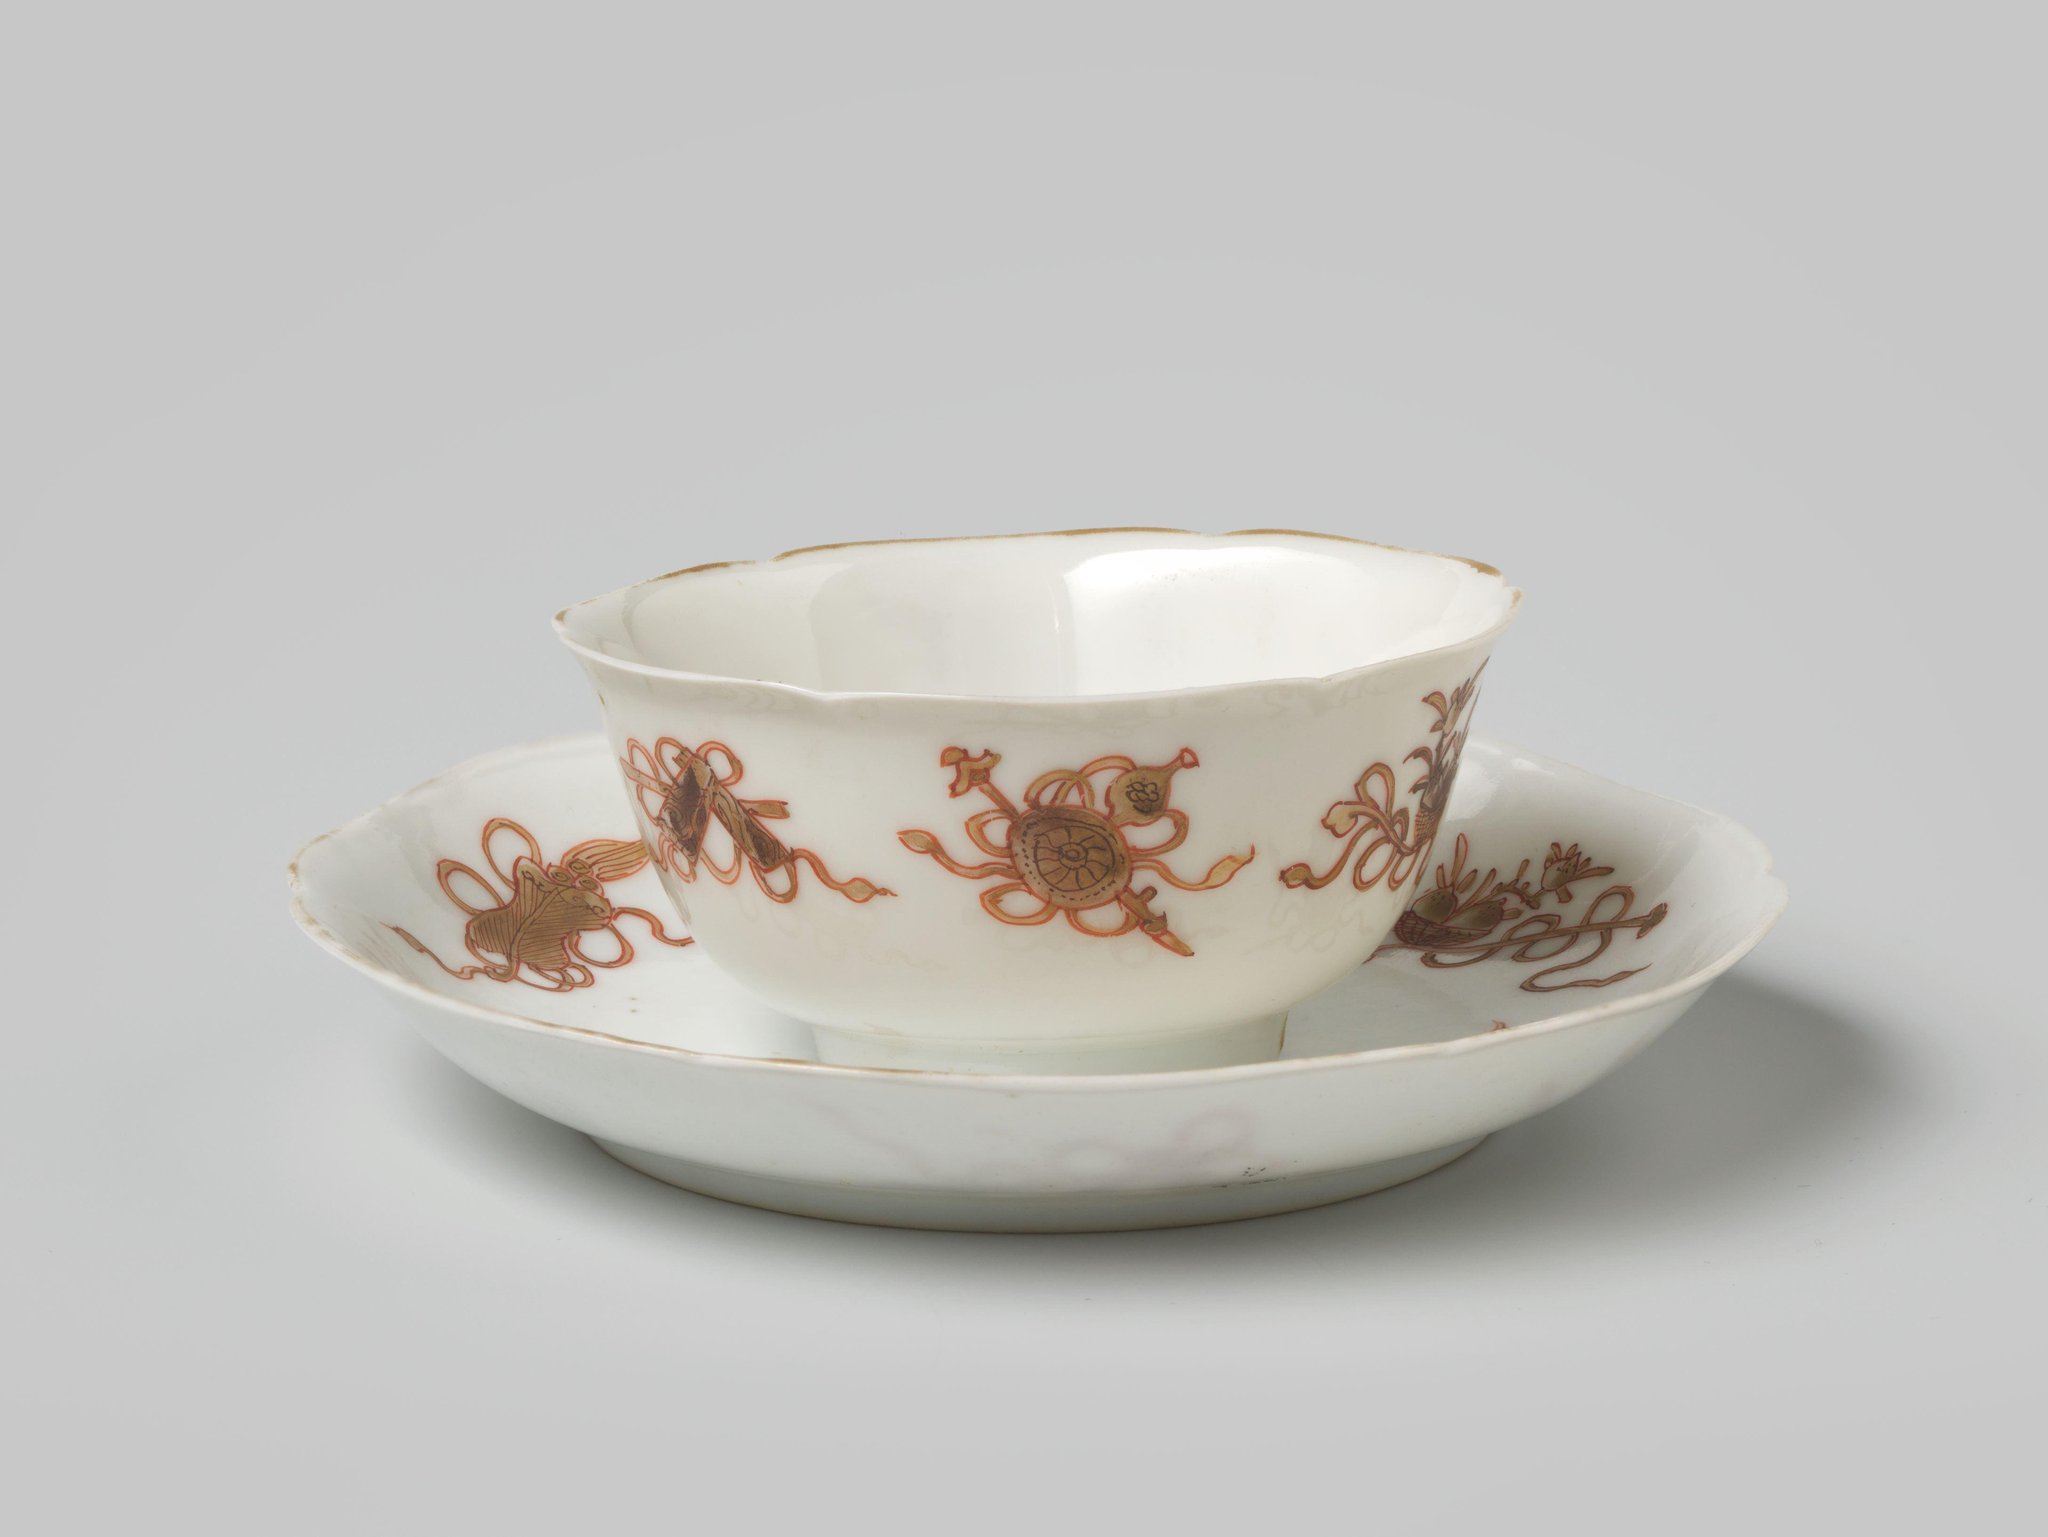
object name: kop en schotel, kop en schotel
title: Cup and saucer with taoist symbols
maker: Anonymous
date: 1700-1724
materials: glaze, paint, porcelain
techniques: firing, gilding, turning, vitrification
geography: china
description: Kop en schotel van porselein met zesmaal gelobde rand, beschilderd op het glazuur in rood en goud. Op het plat van de schotel een bloemenmand met paddestoelen (lingzhi), hieromheen de acht taoïstische symbolen (kalebas, fluit, castagnetten, slaginstrument, lotus, waaier, zwaard, fruitmand); kop met dezelfde decoratie. Bodem van de kop met barsten. Melk en bloed.